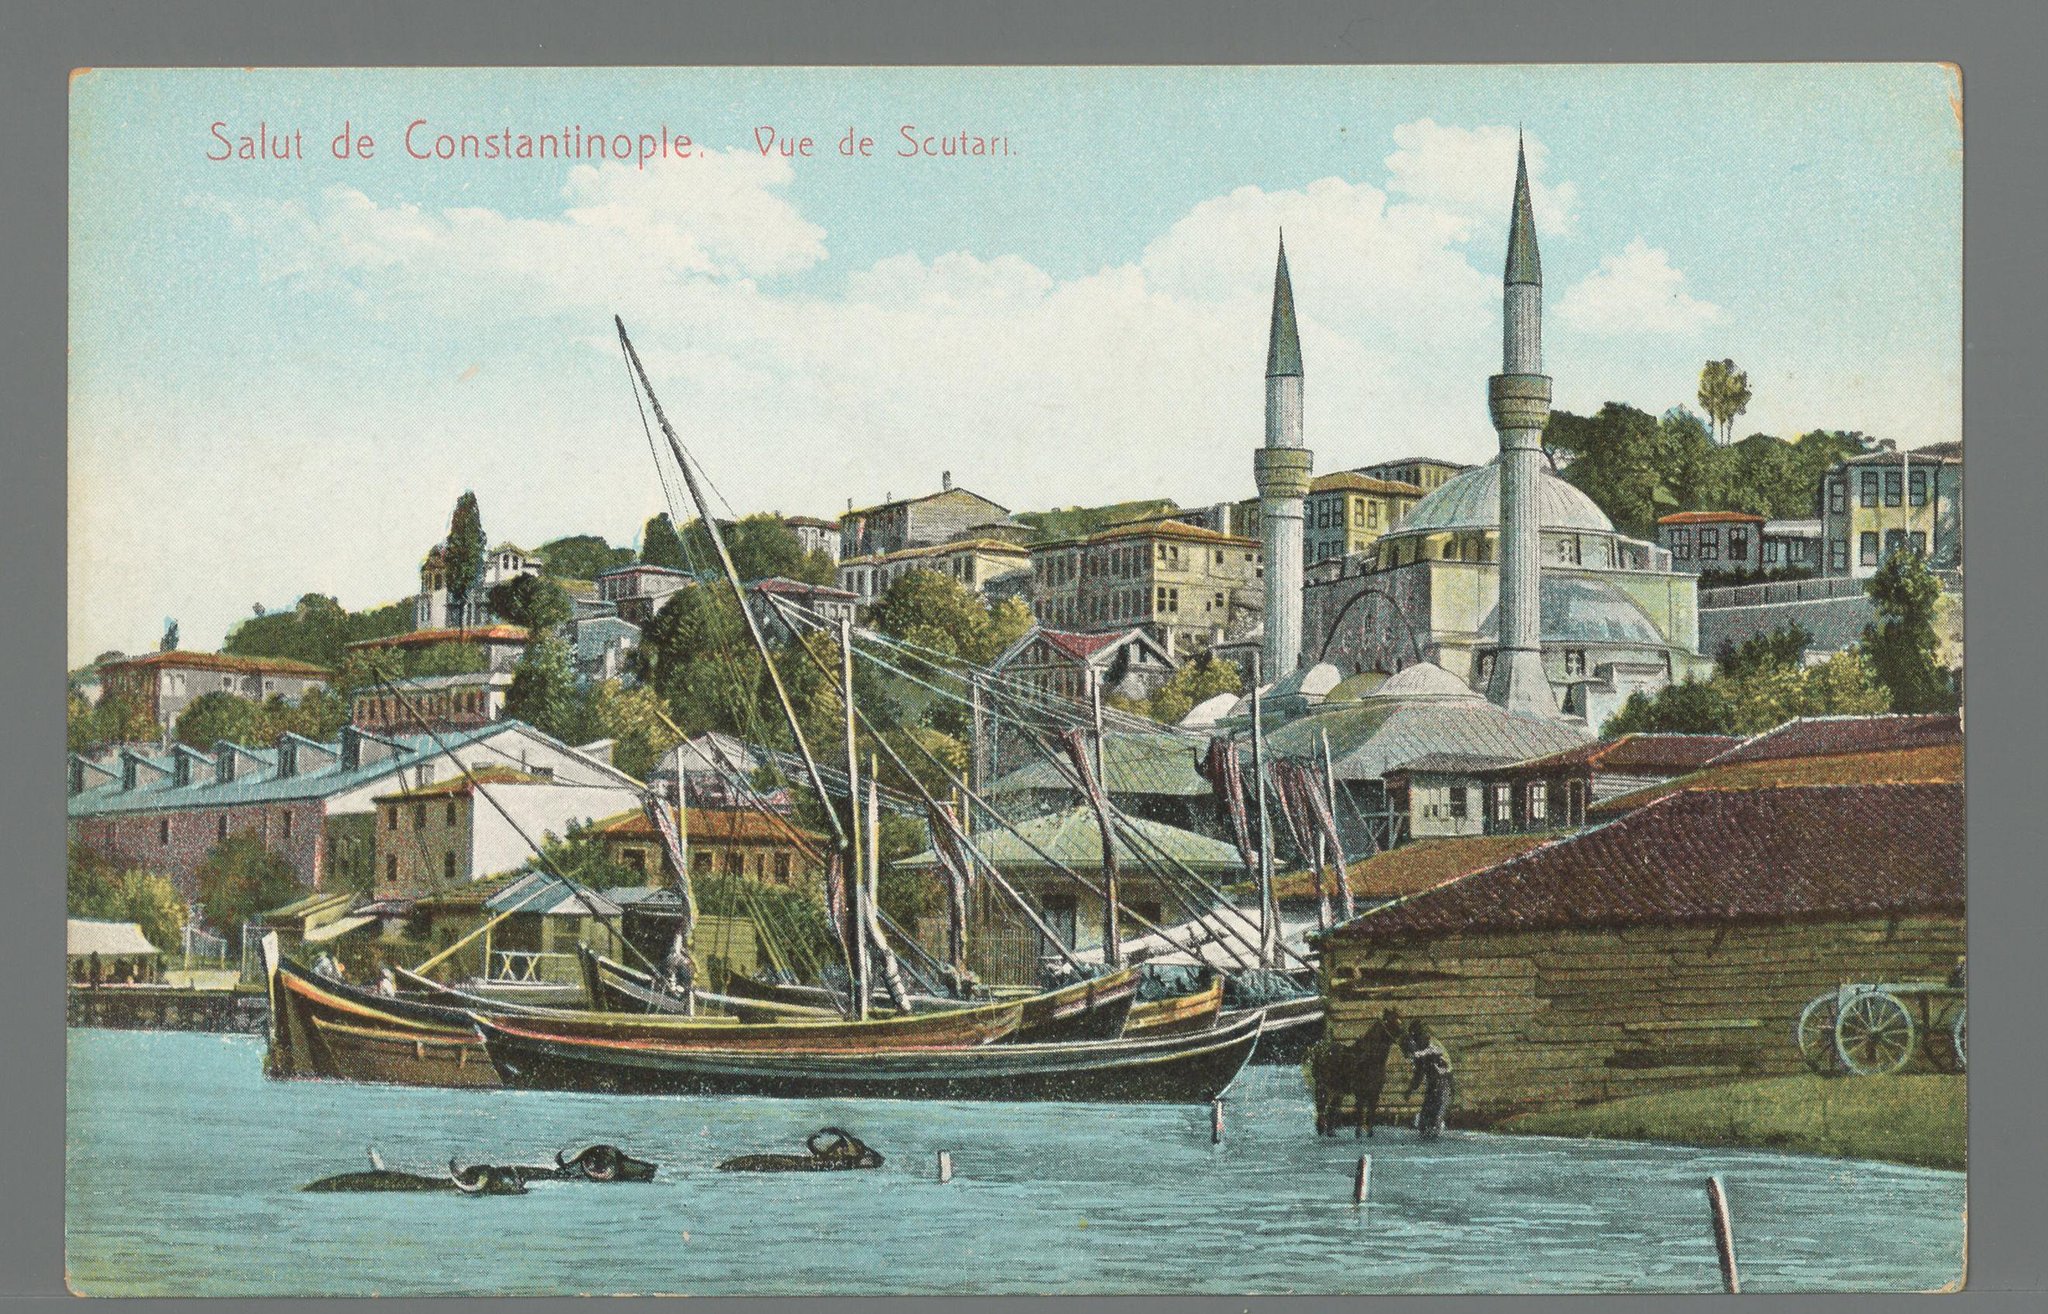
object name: ansichtkaart, prentbriefkaart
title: Vue de Scutari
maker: Anonymous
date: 1906-1920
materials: cardboard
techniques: lithograph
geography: constantinople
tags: temple, shrine ~ islam, mohammedanism, prospect of city, town panorama, silhouette of city (+ city(-scape) with figures, staffage)